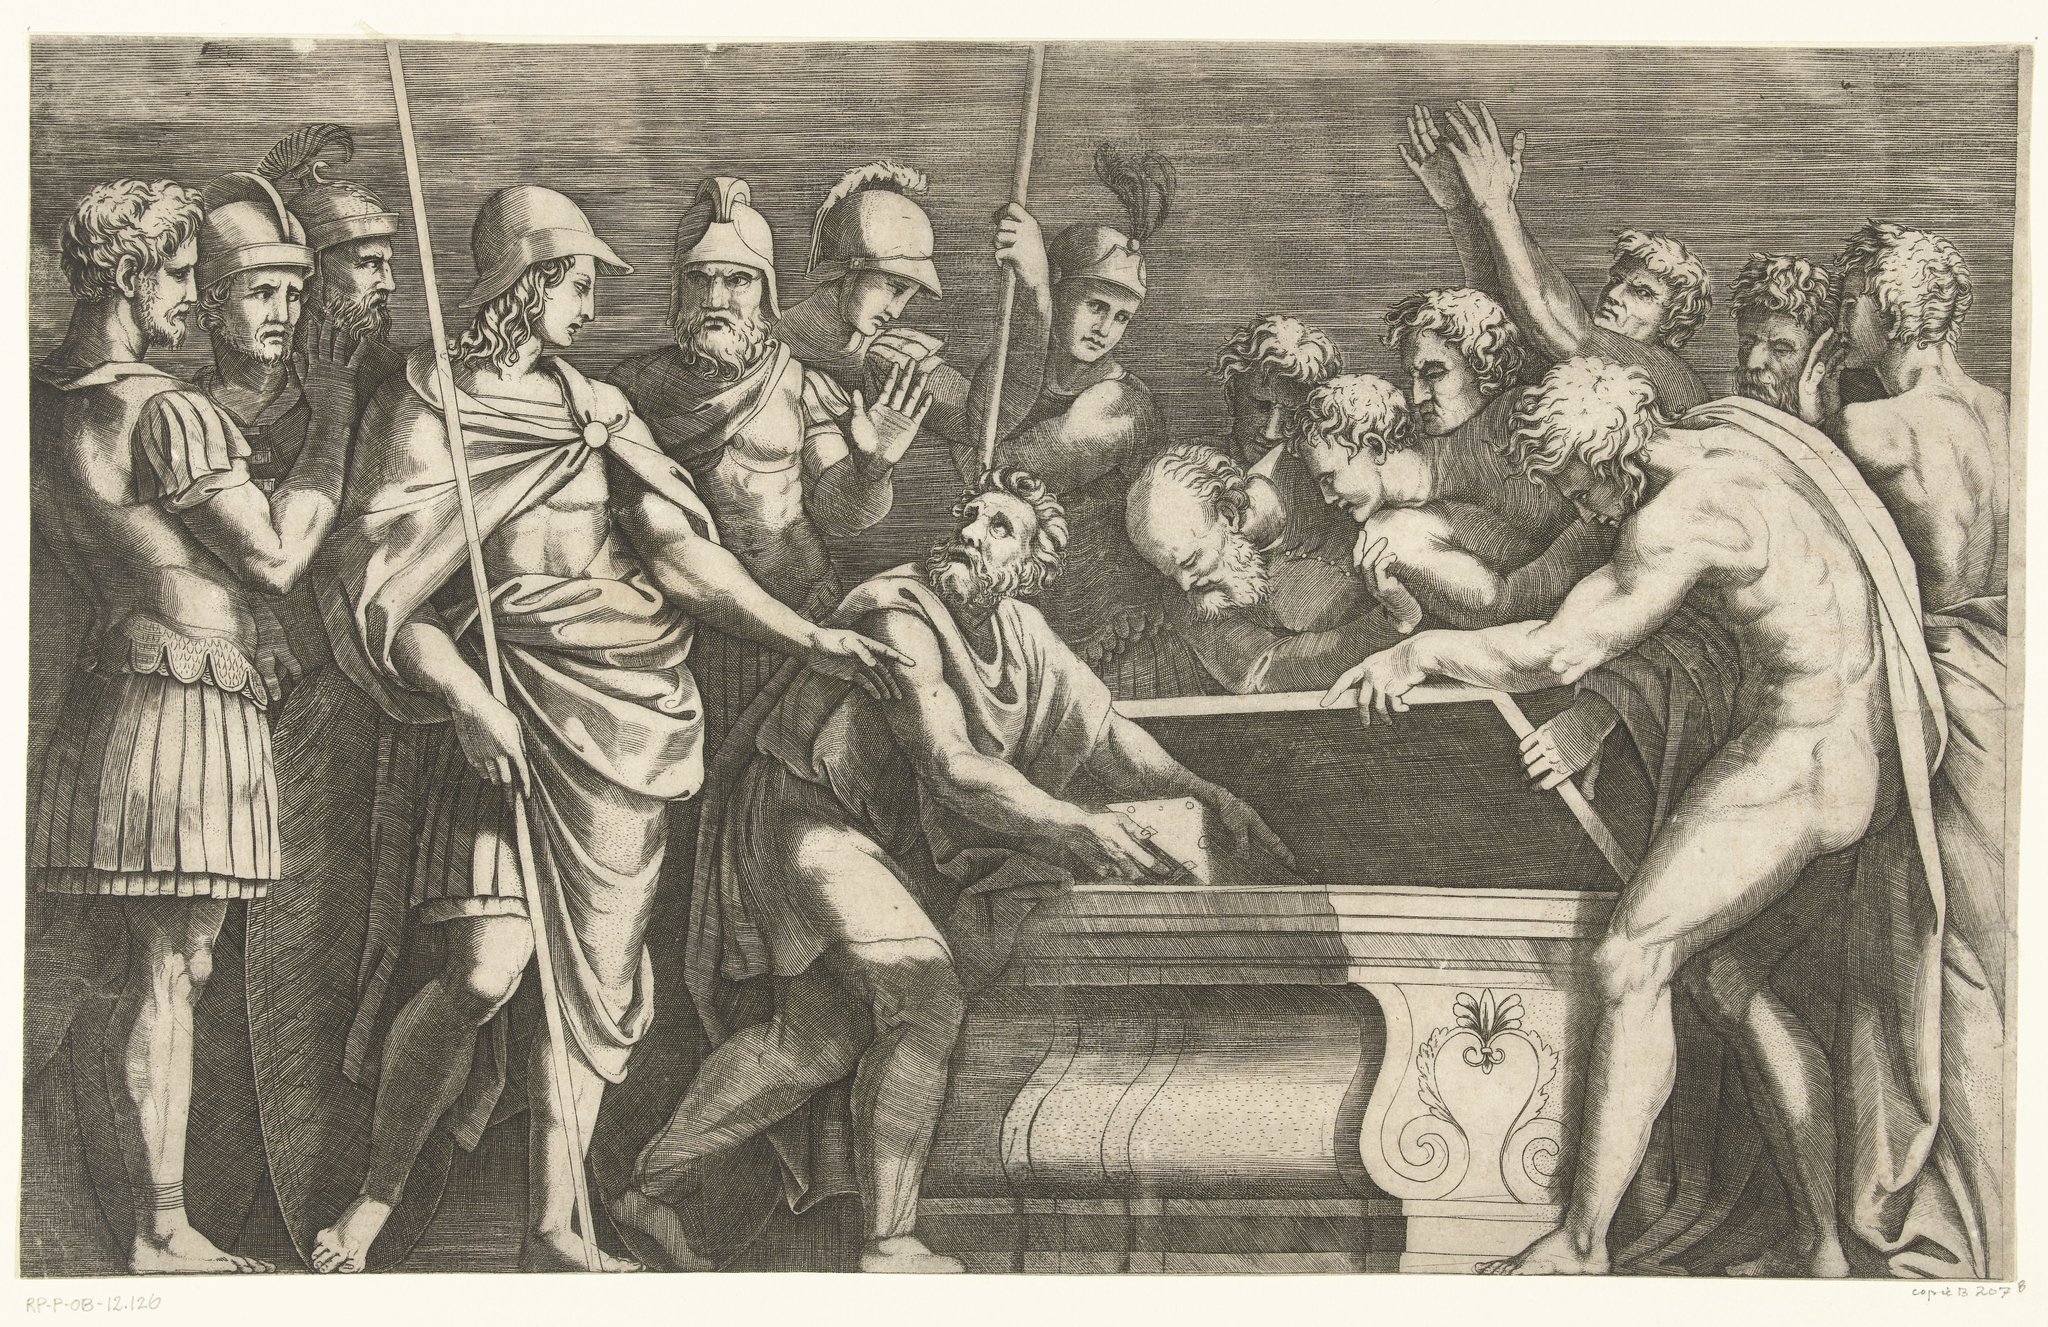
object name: print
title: Alexander de Grote laat de werken van Homerus veilig opbergen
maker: Anonymous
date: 1515-1575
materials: paper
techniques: engraving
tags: alexander has the books of homer put into a chest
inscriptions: collector's mark: Lugt 240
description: Kopie naar prent van Marcantonio Raimondi. Raimondi baseerde zijn prent op een ontwerp van Raphael voor een grisaille in de Stanza della Segnatura, Vaticaan, Rome (tekening in collectie Ashmolean Museum, Oxford).